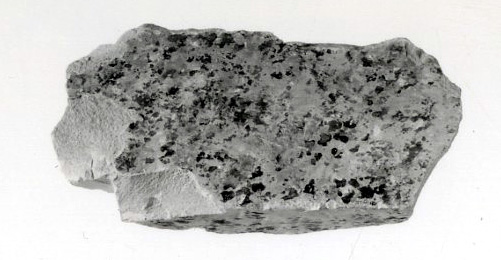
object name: relief fragment, tomb of meketre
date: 1981-1975 BCE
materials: limestone, paint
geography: egypt